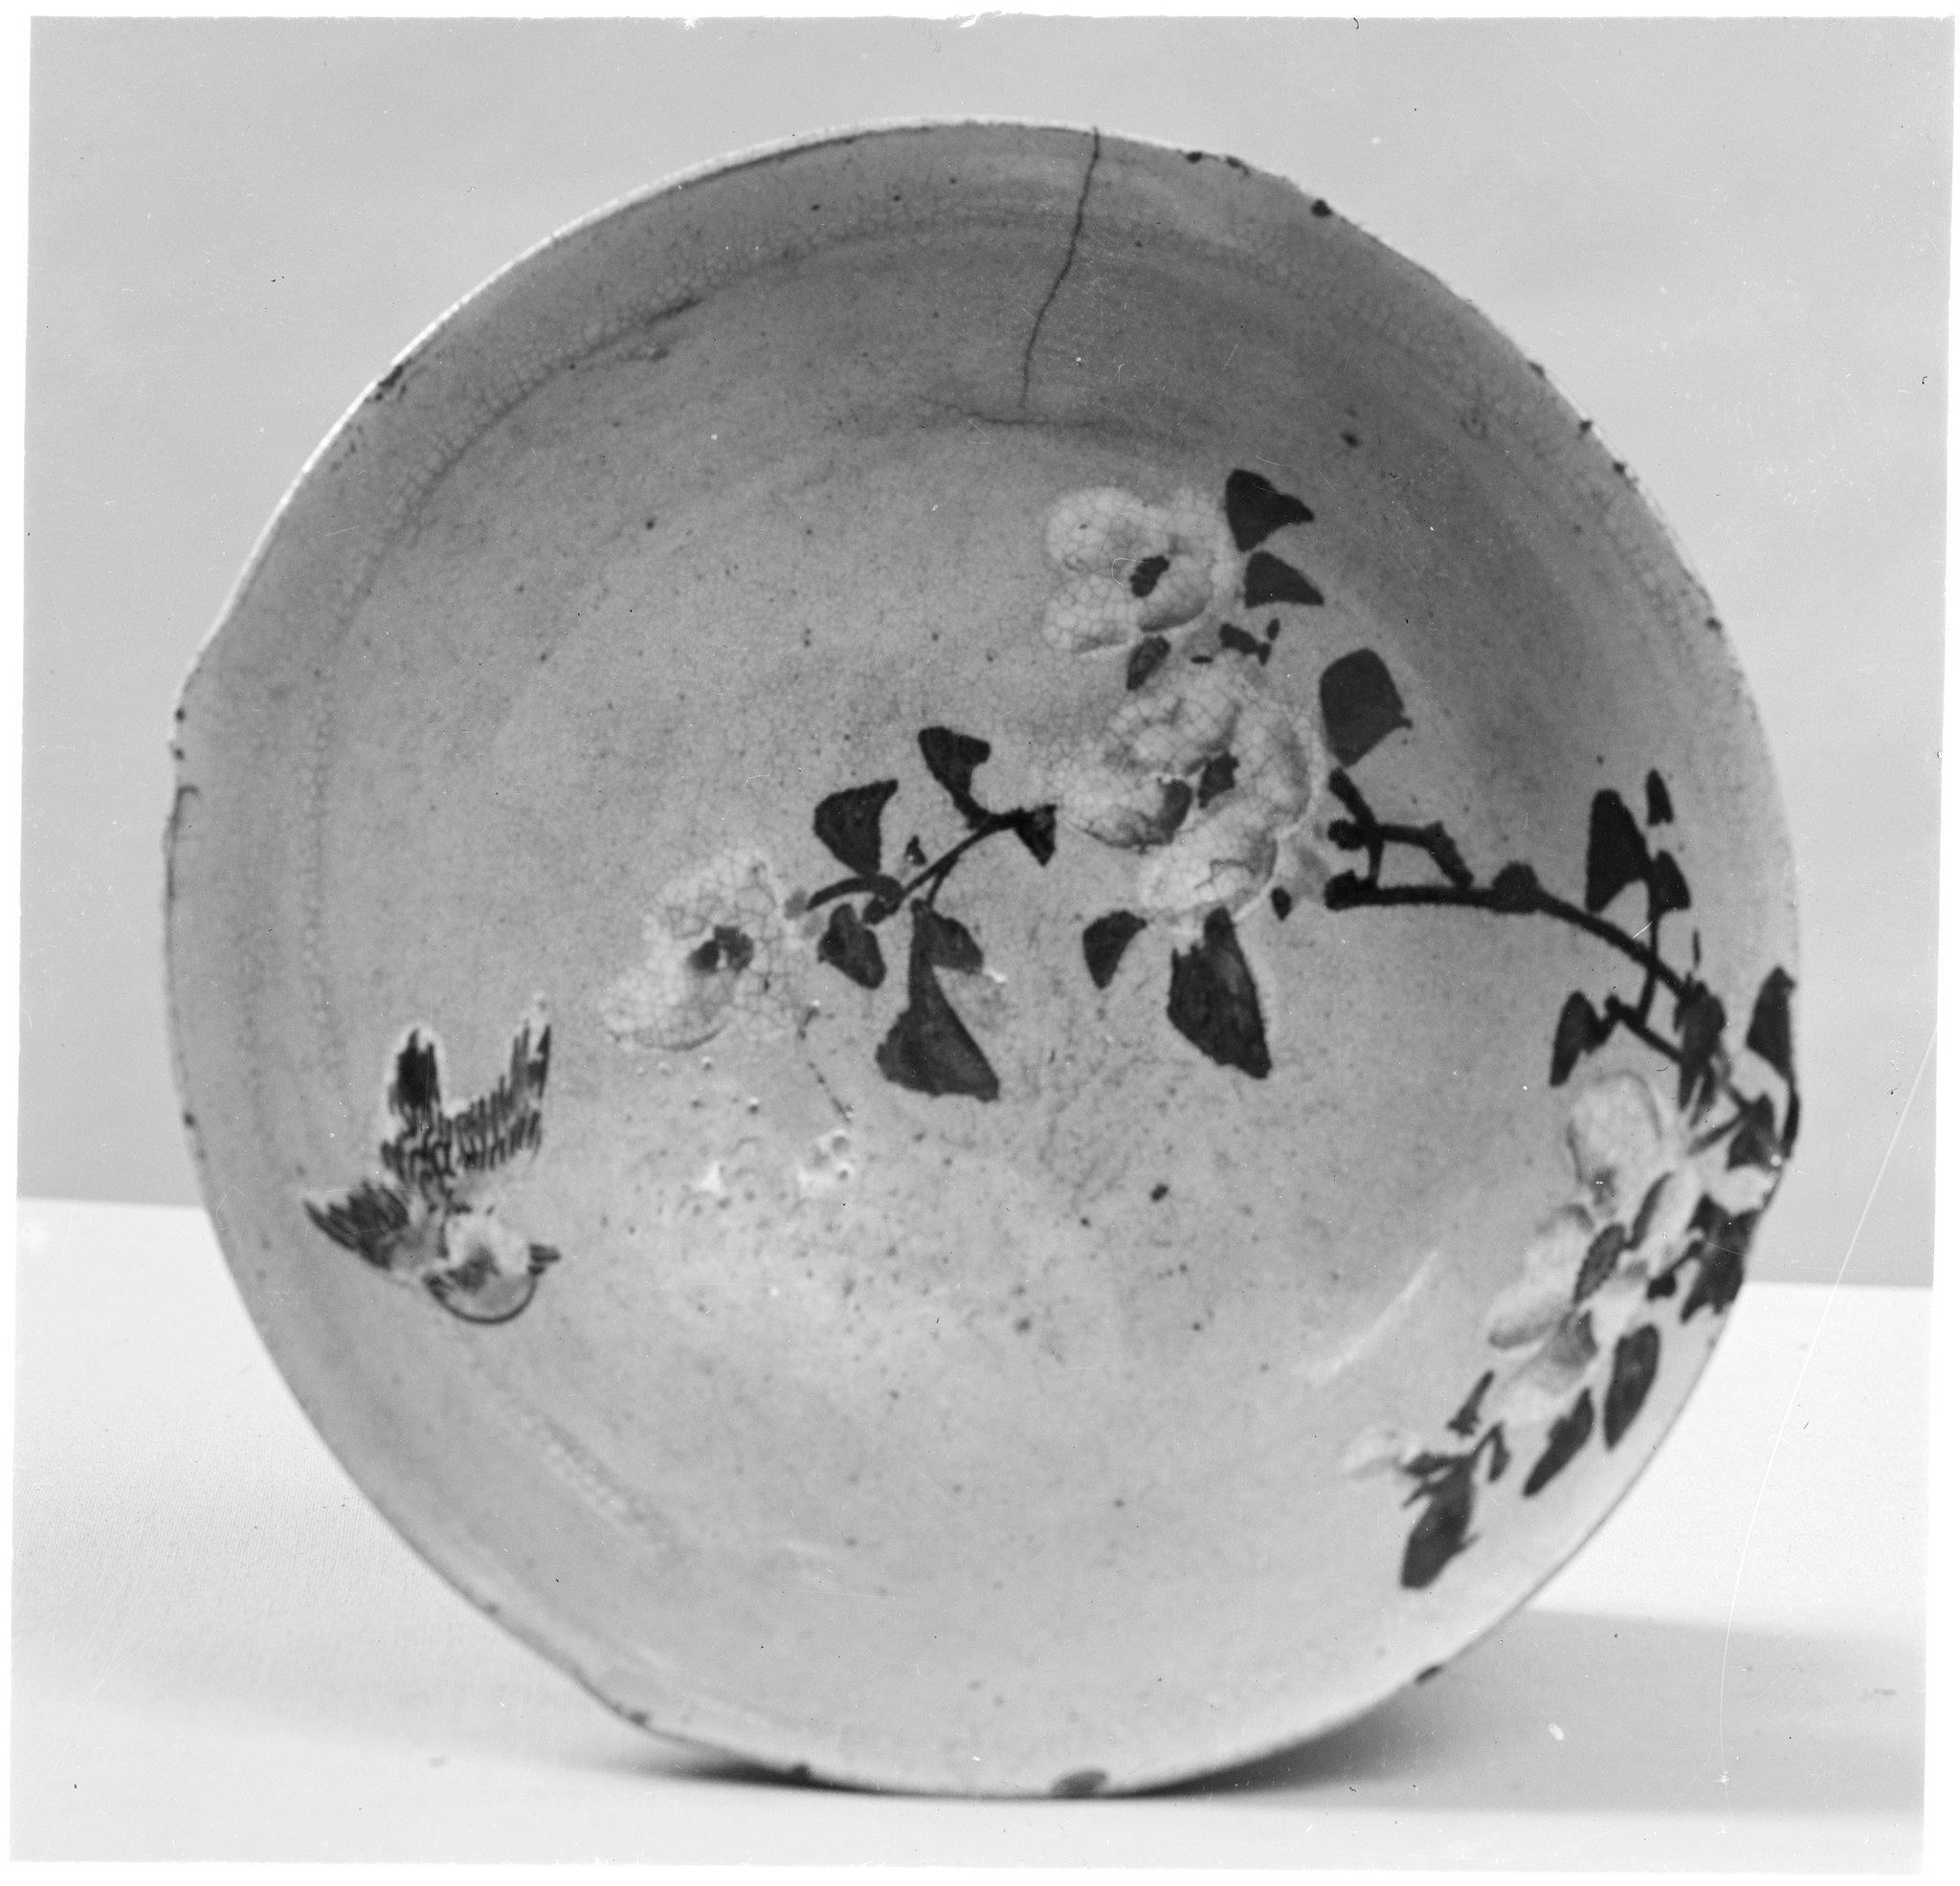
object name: teabowl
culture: japanese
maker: yosobei ii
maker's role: artist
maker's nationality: japanese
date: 1830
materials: clay, enamel, glaze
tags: leaves